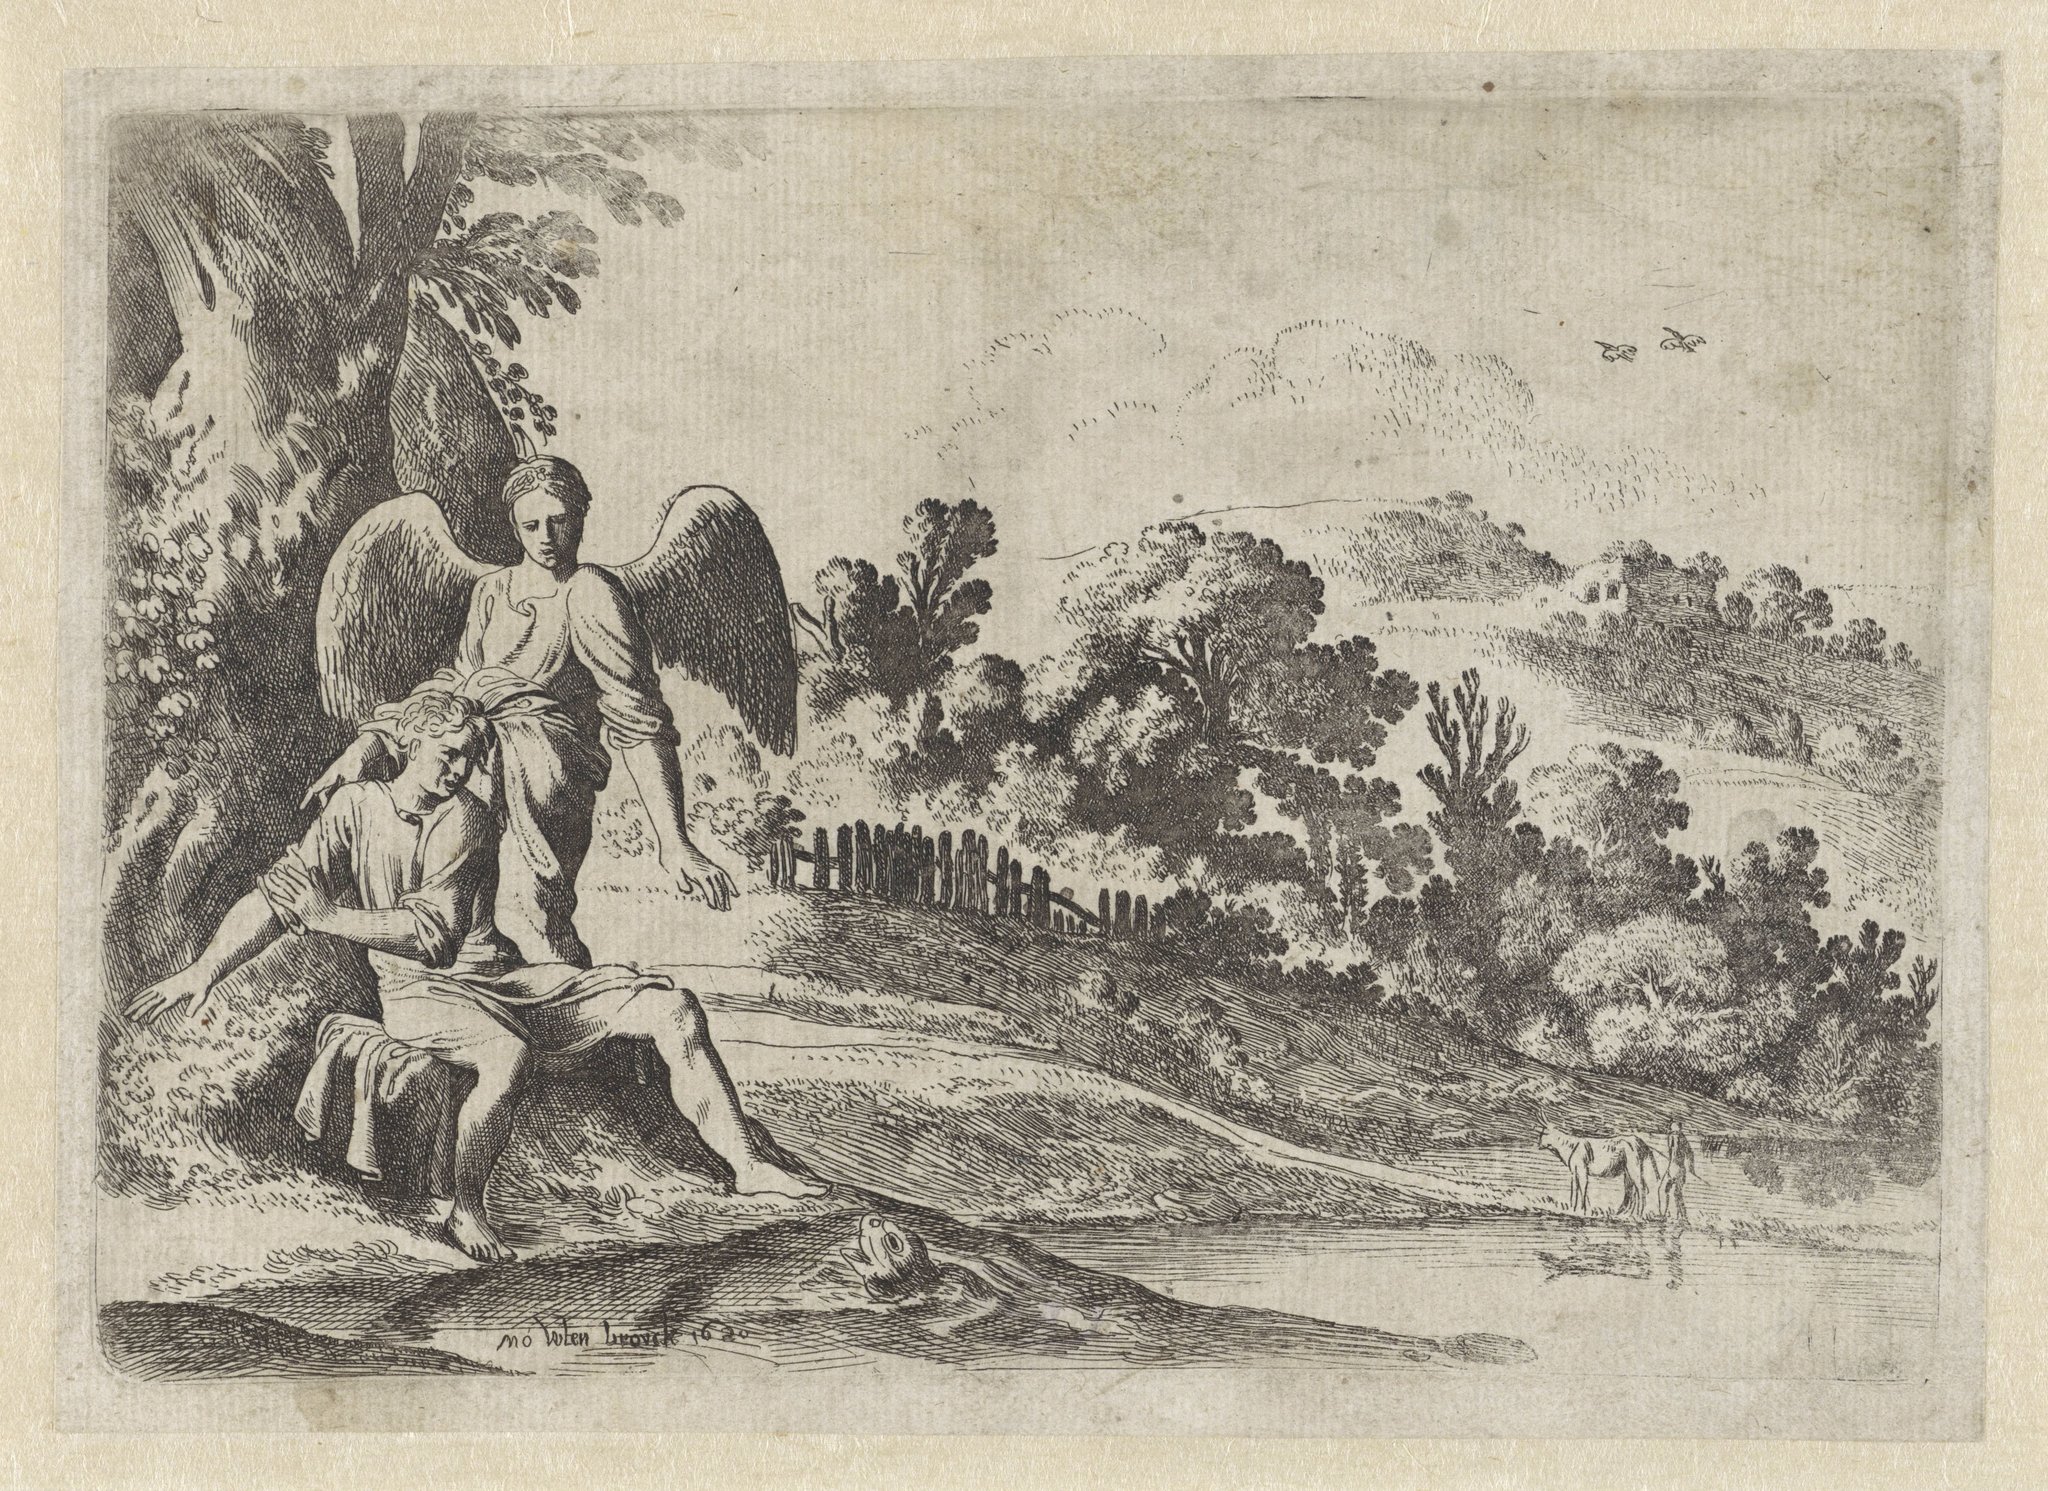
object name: print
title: Tobias schrikt van de vis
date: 1620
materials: paper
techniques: engraving, etching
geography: the hague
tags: a large fish appears while tobias is washing his feet; he is frightened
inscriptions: collector's mark: Lugt 2610, collector's mark: Lugt 2228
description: Tobias zit langs de kant van het water en deinst terug als hij de vis in het water ziet. De engel staat achter hem. Genummerd als II in de rechterbenedenhoek.